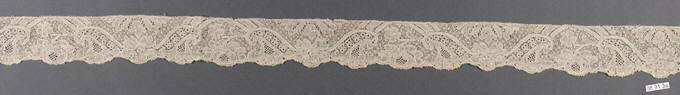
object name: border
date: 1701-1733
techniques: lace